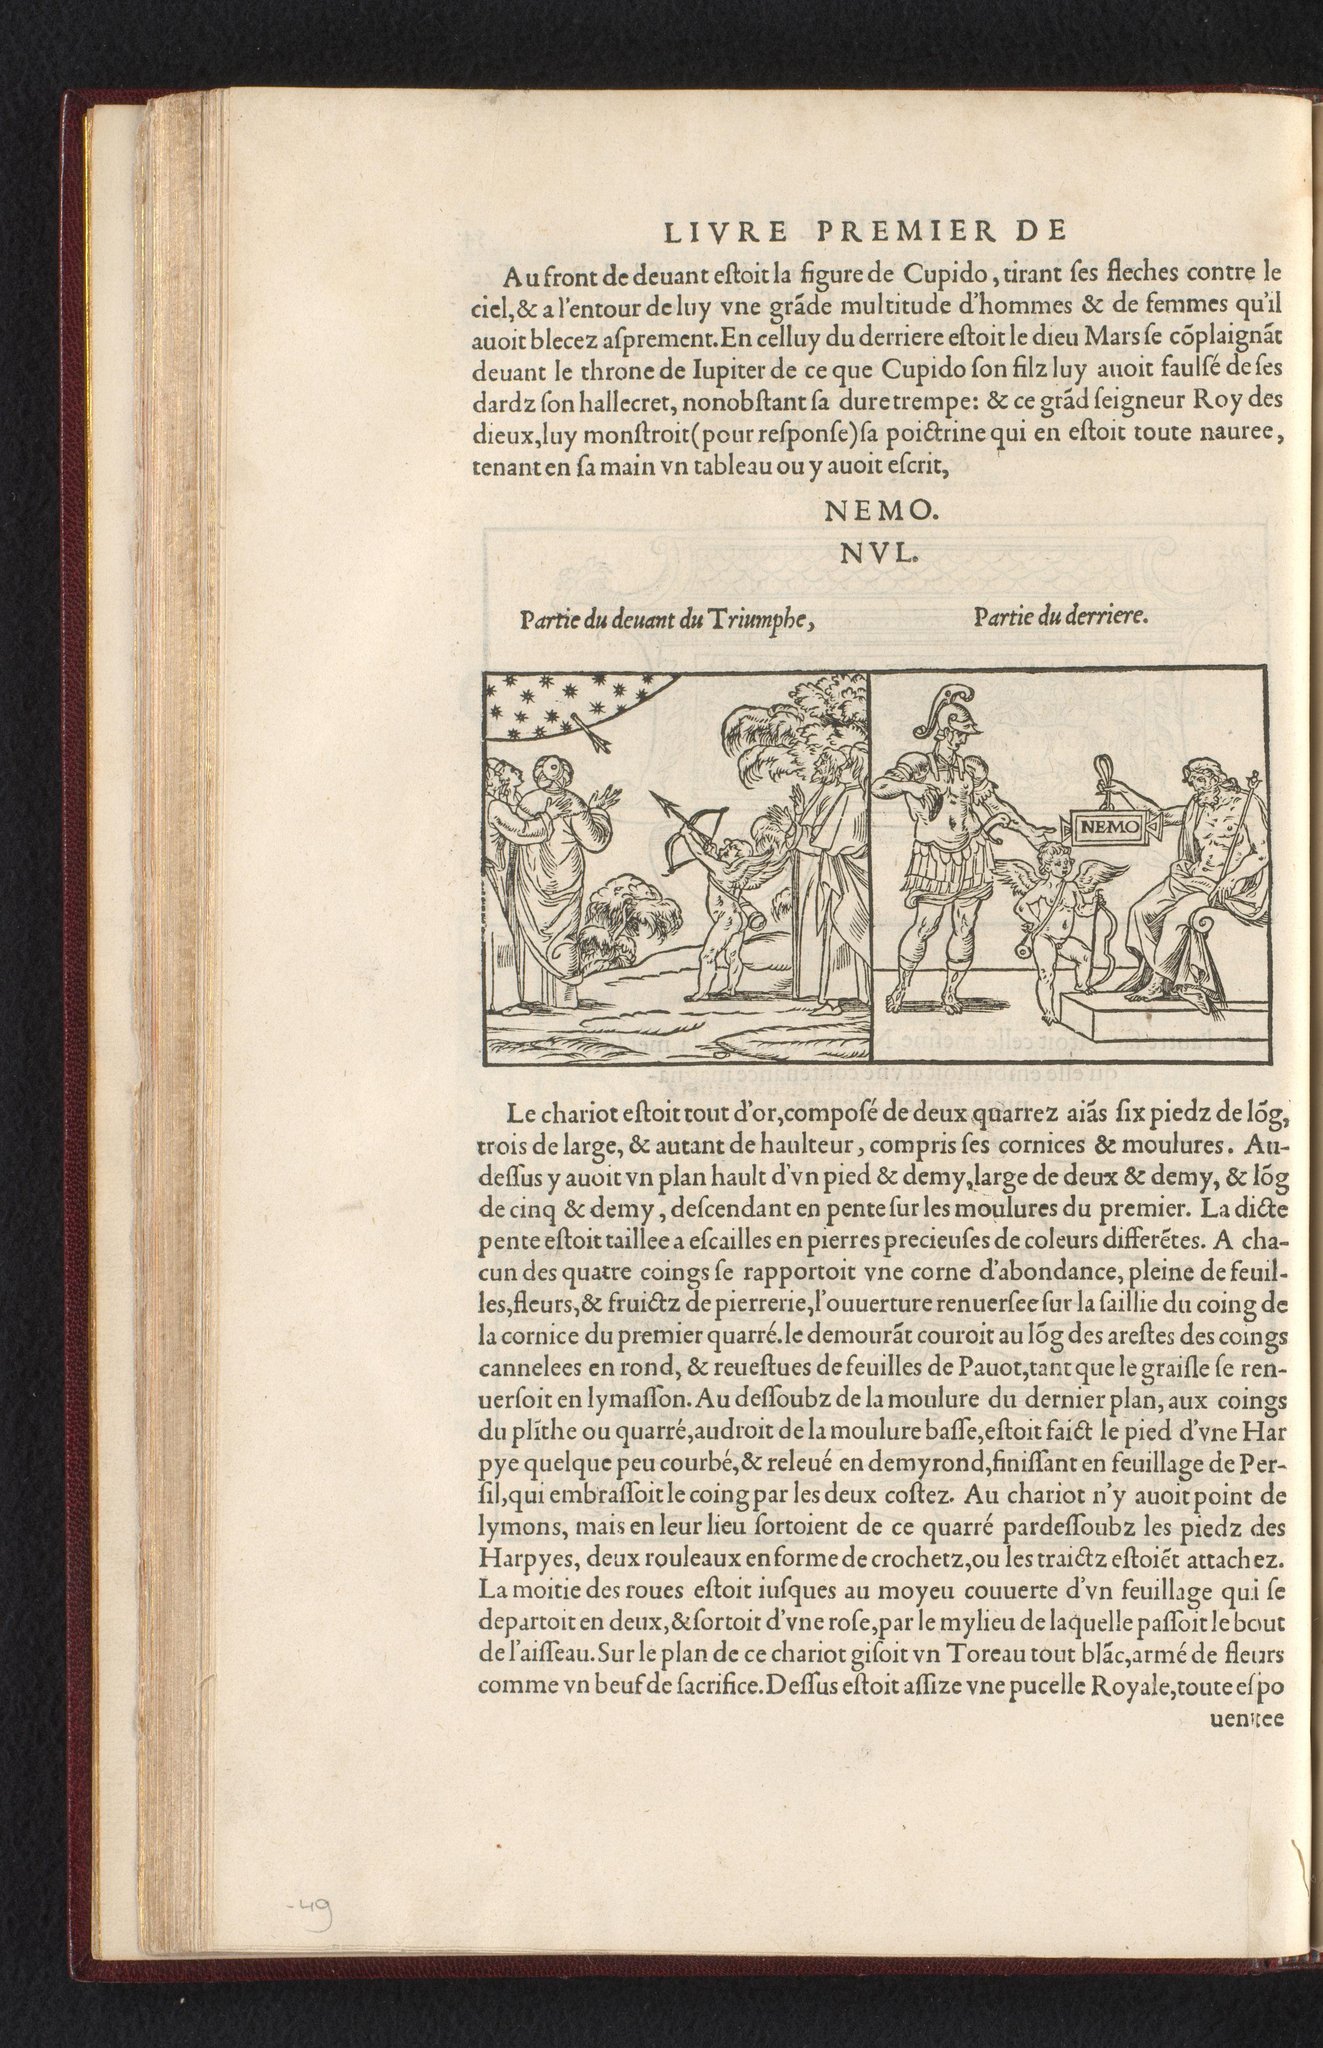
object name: book illustration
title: Cupido schiet een pijl naar de sterren en Cupido met Mars bij de troon van Jupiter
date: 1546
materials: paper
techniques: letterpress printing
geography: paris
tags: (story of) mars (ares), (story of) jupiter (zeus), (scenes from) specific works of literature: colonna, hypnerotomachia poliphili, throne, (story of) cupid, amor (eros)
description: Prent uit: Colonna, Francesco. Hypnerotomachie ou discours du songe de Poliphile, deduisant comme amour le combat a l'occasion de Polia. Parijs: Jacques Kerver, 1546, verso fol. 54.